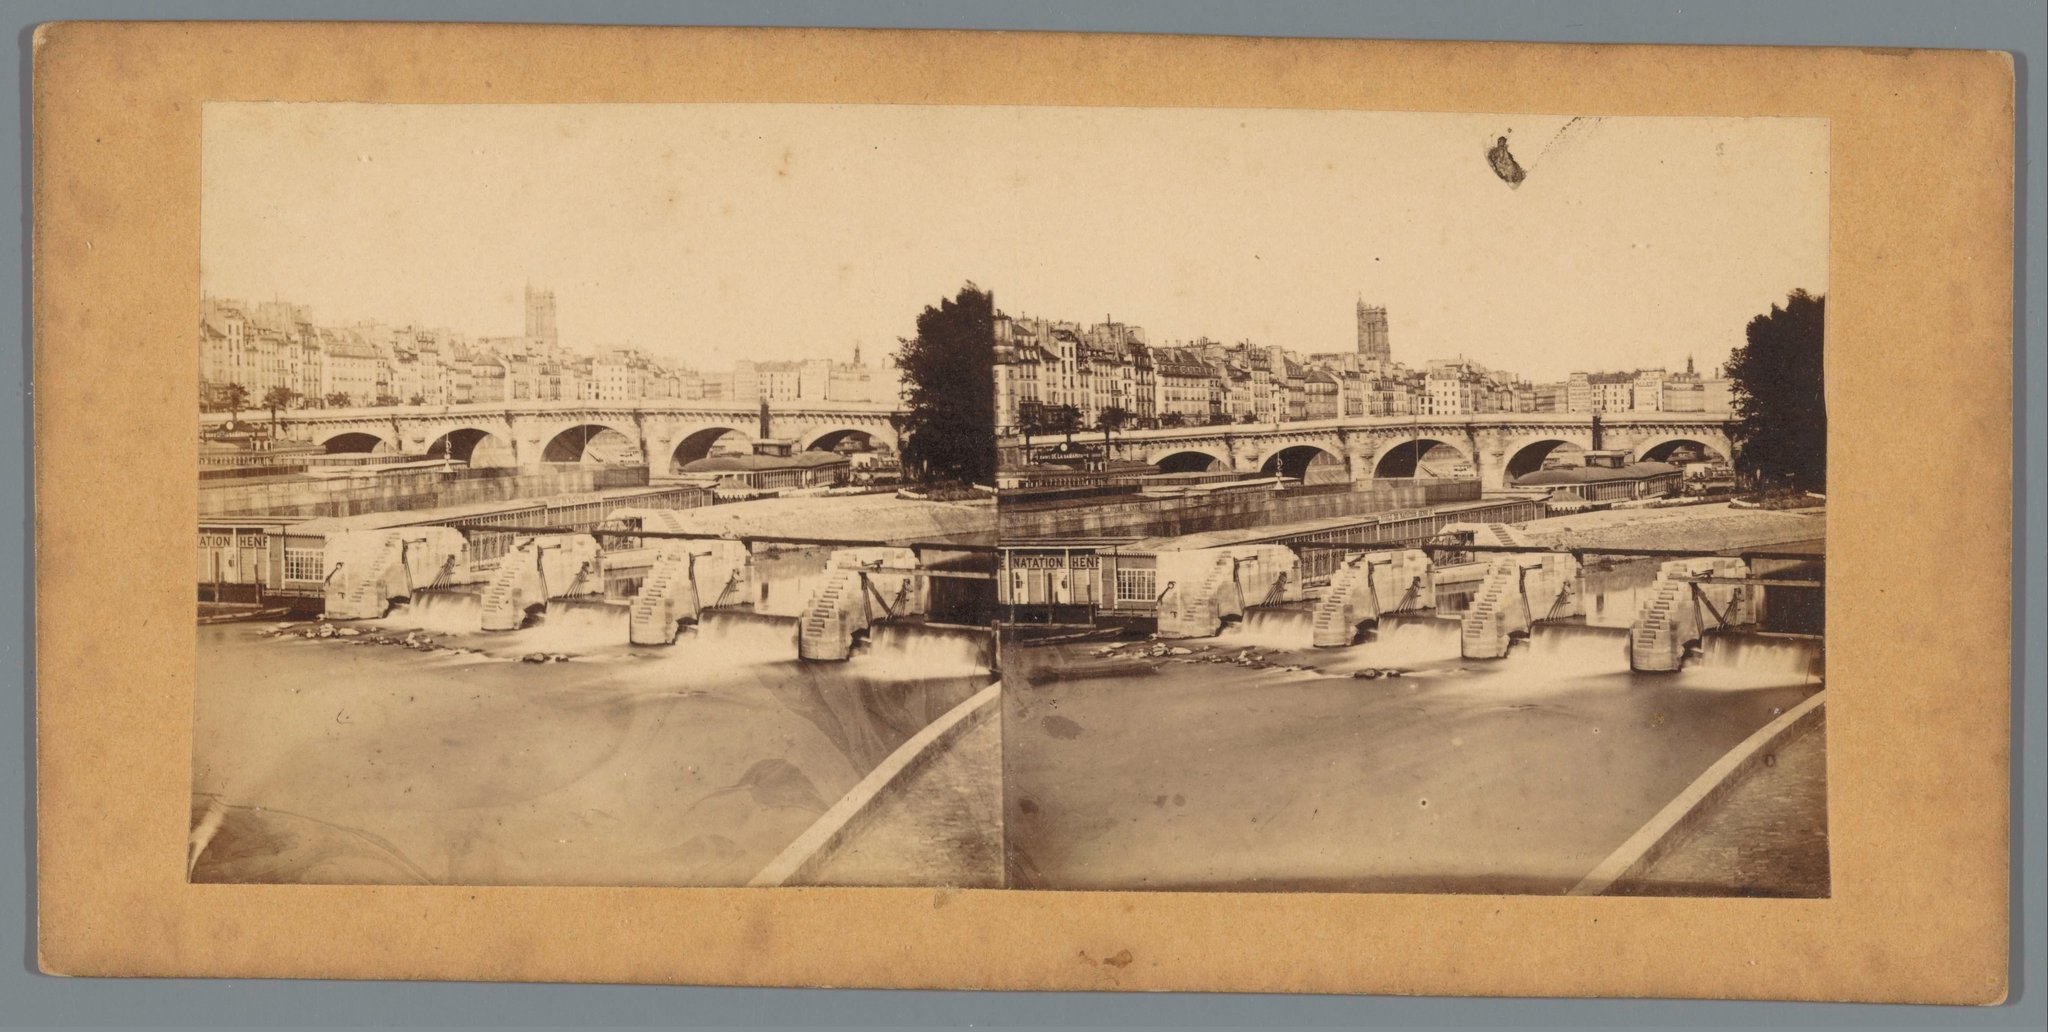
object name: stereograph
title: Sluizen in de Seine in Parijs bij Pont Neuf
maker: Anonymous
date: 1855-1860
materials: cardboard, photographic support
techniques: albumen print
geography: paris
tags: sluice, weir, bridge in city across river, canal, etc.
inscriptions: inscription: ‘Ecluse de la Seine [...] pont neuf’